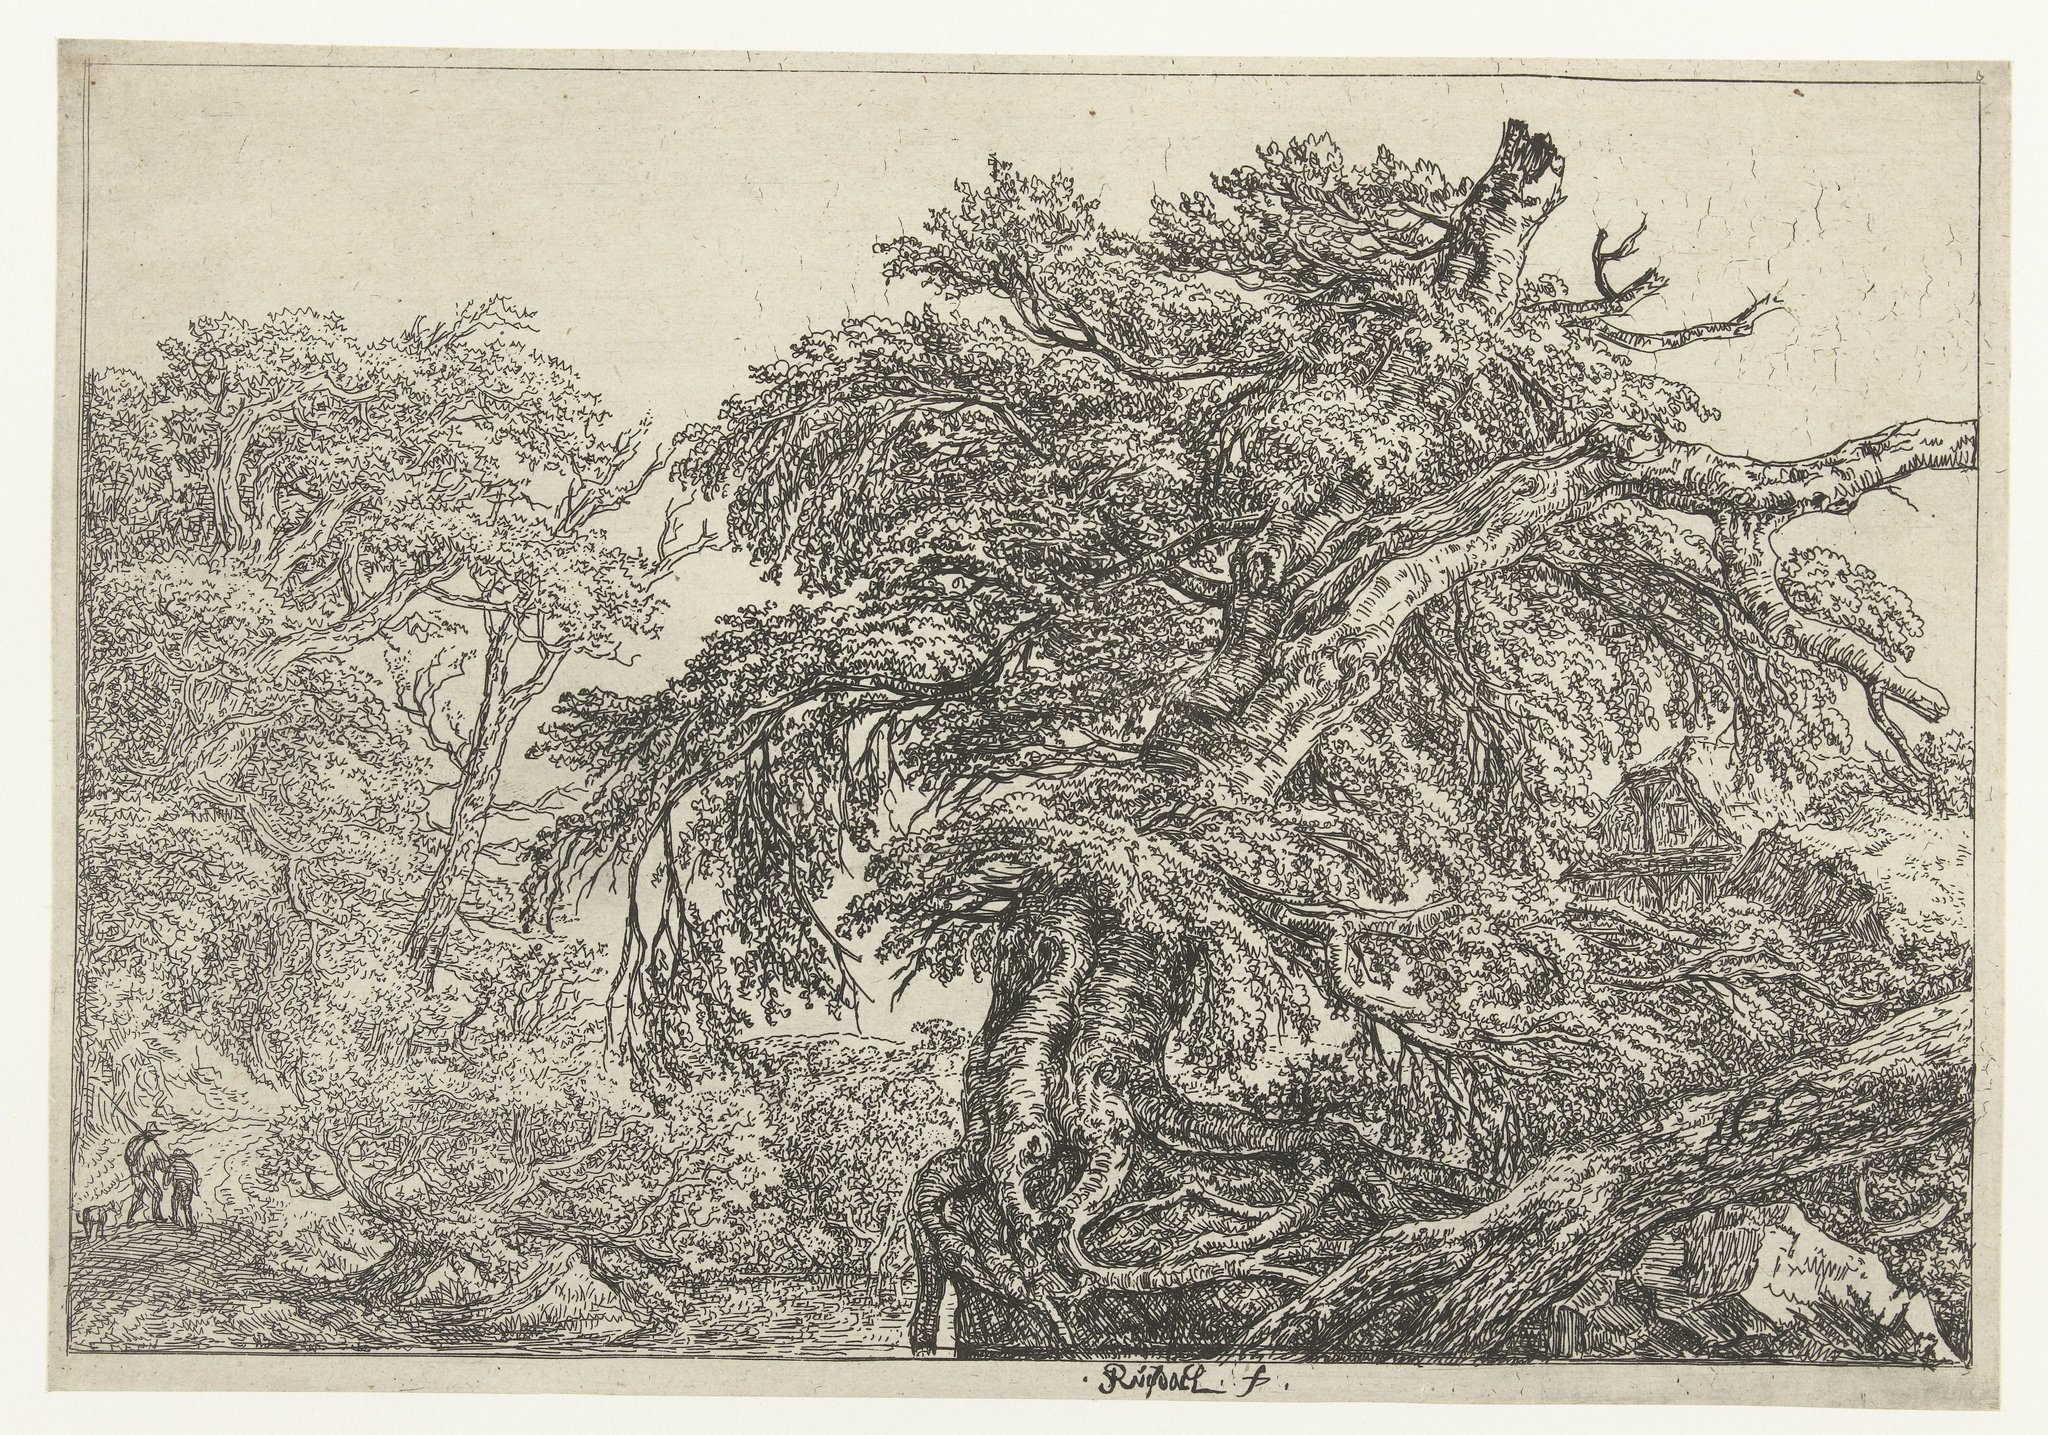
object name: print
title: Twee boeren met hun hond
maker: jacob isaacksz van ruisdael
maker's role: draughtsman, painter, print maker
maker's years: 1628-1682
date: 1650-1655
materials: paper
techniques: etching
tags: trees: beech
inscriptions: collector's mark: Lugt 240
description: Grote beuk in een boslandschap met rechts een huis en links twee boeren met een hond.